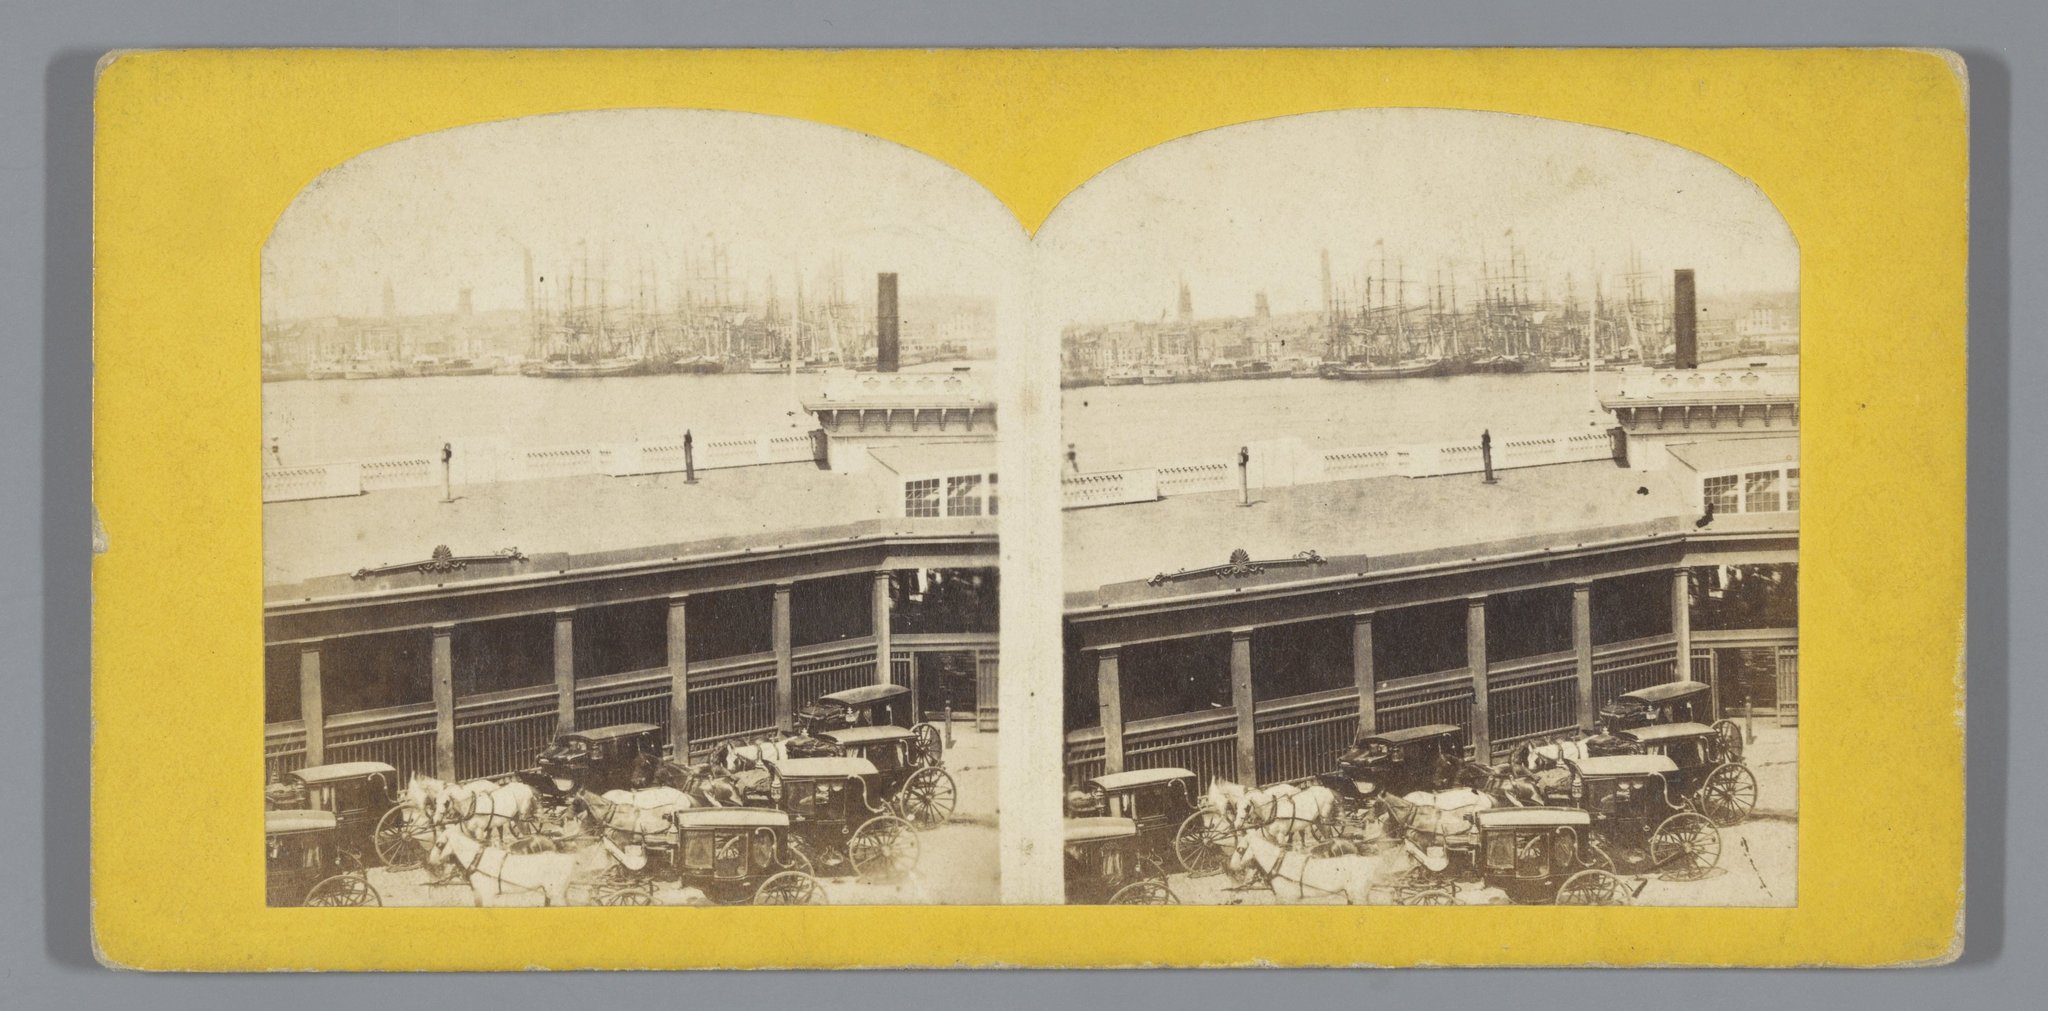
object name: stereograph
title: The Hoboken Ferry, New York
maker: Anonymous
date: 1868-1890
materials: cardboard, paper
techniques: albumen print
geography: new york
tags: ferry, new york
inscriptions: title: ‘The Hoboken Ferry./ New York. 35-4.’